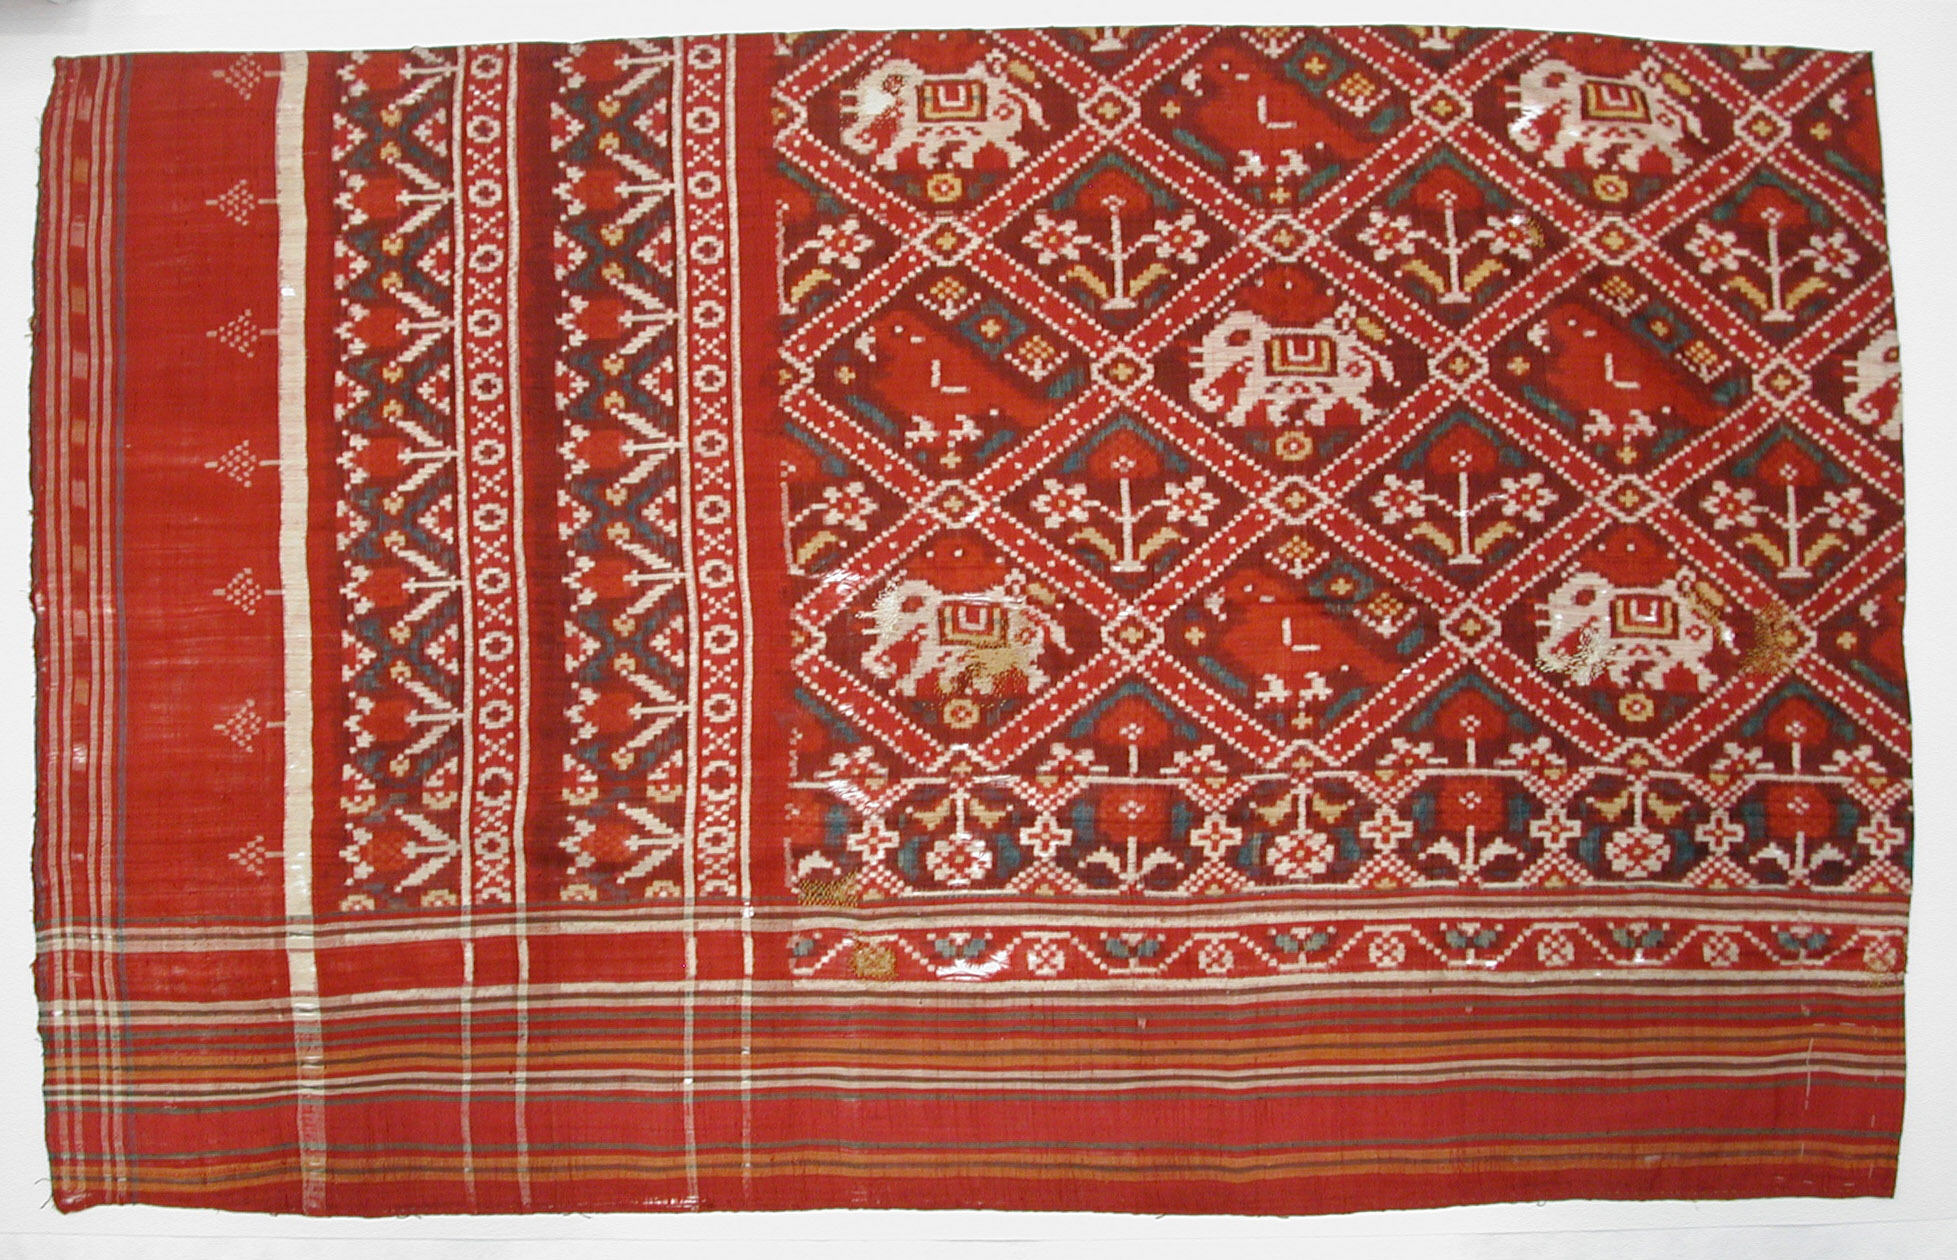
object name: sari fragment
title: Fragment of Sari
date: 1701-1900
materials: silk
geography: pakistan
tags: elephants